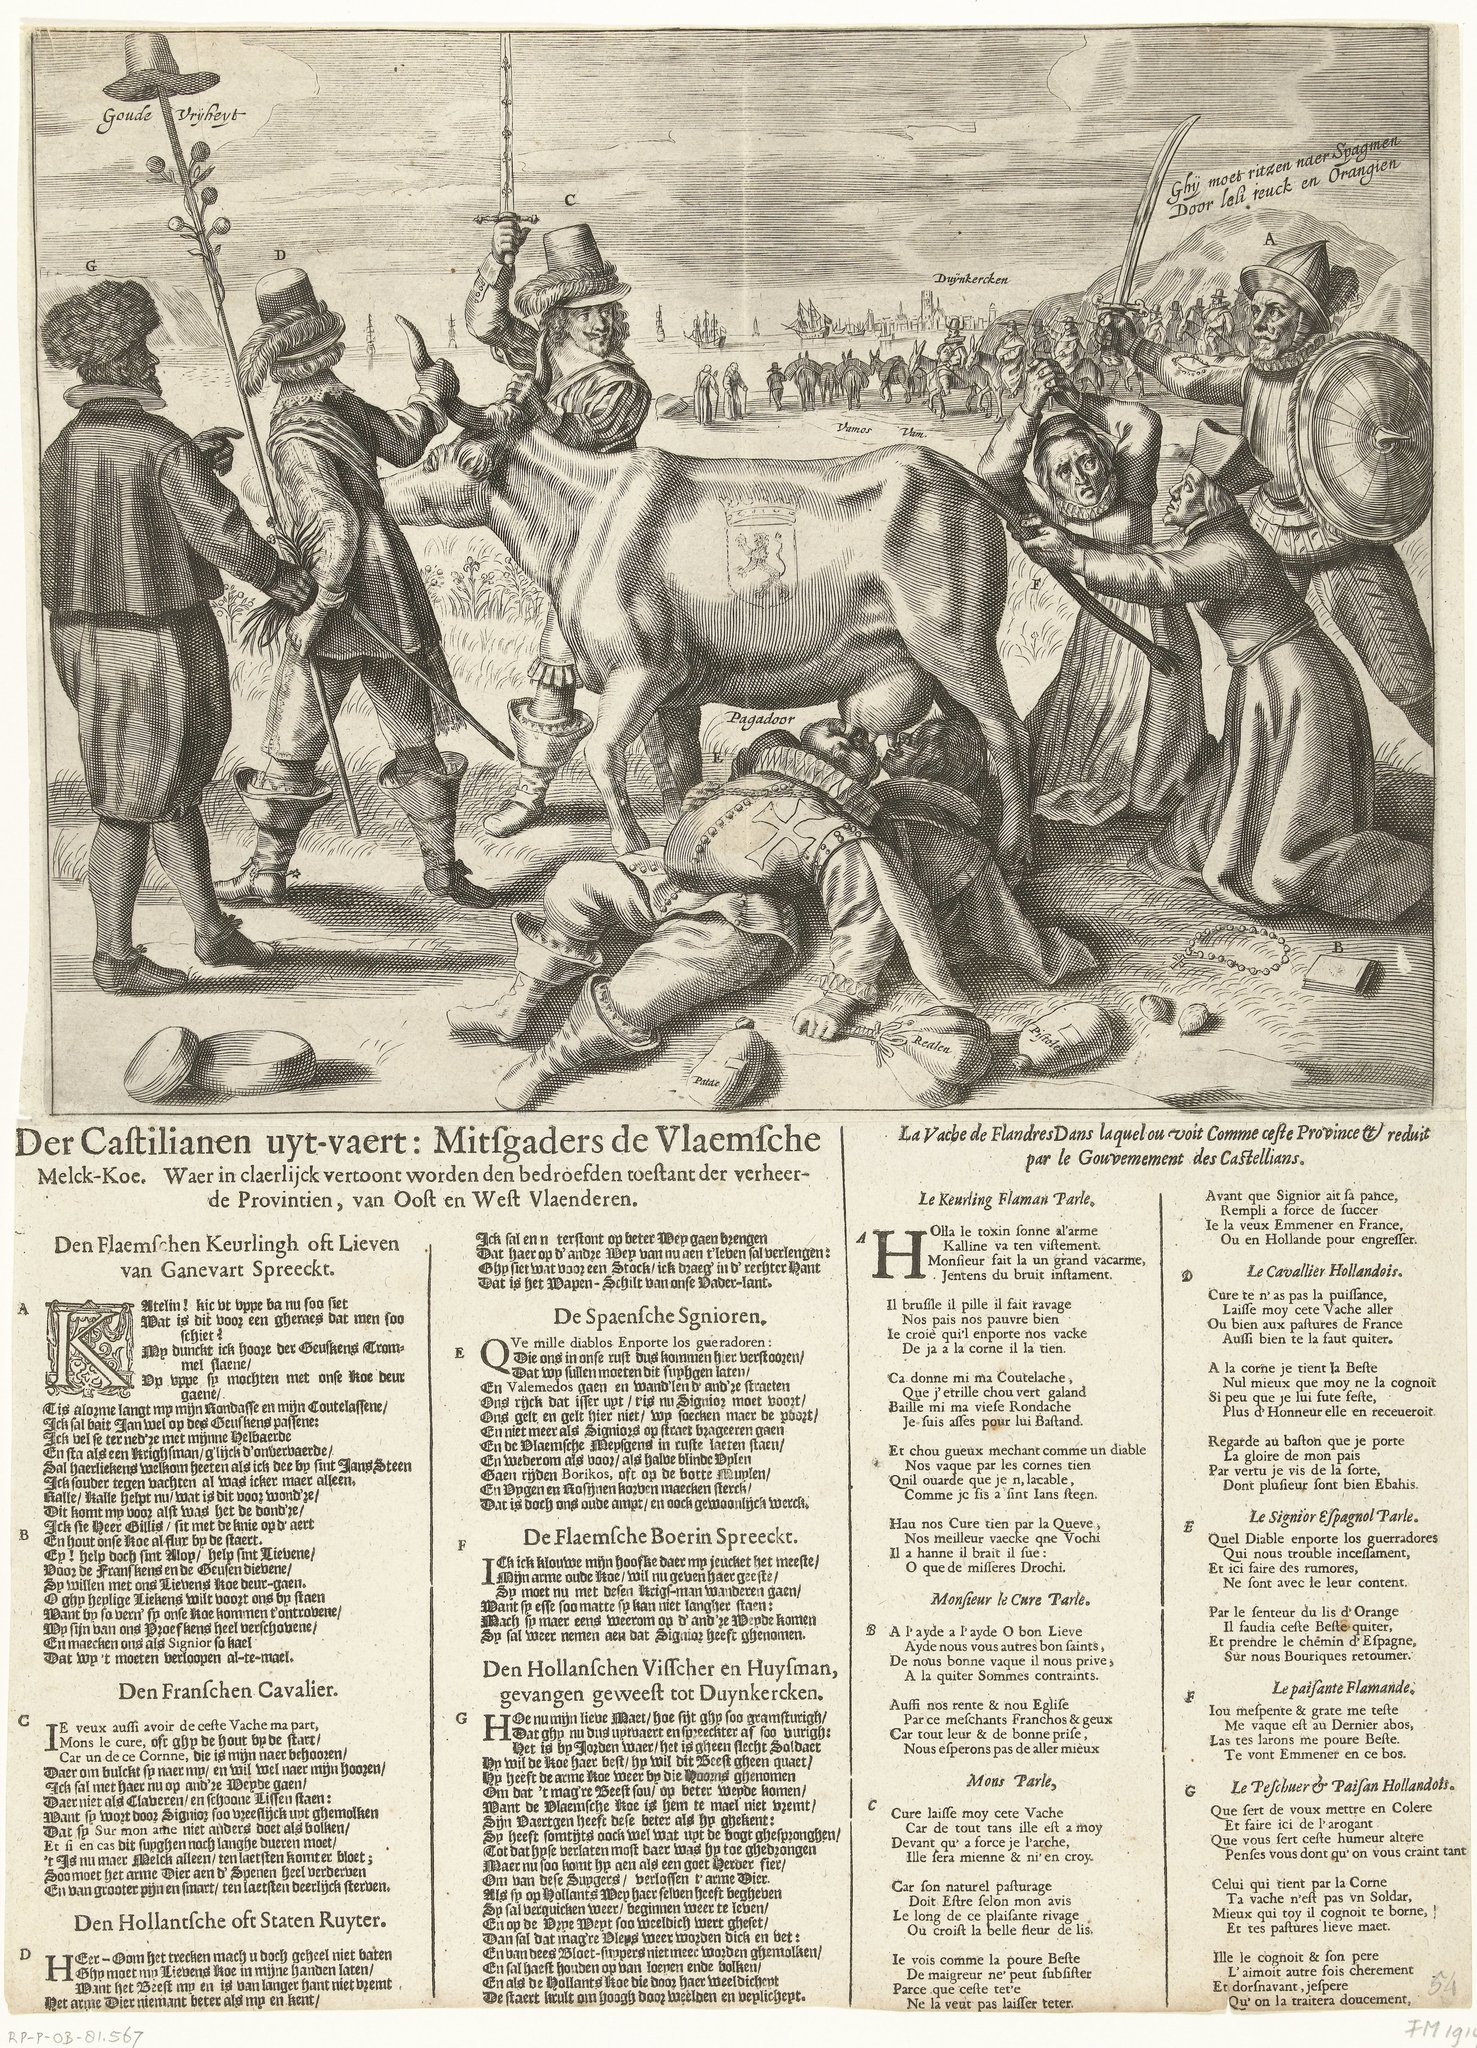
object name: print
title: Spotprent op het Spaanse verlies van Duinkerken, 1646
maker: crispijn van de passe (ii)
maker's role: draughtsman, print maker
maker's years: 1594-1670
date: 1646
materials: paper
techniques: engraving, letterpress printing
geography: northern netherlands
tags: cow, political caricatures and satires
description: Spotprent op de verovering van Duinkerken door het Franse leger op de Spanjaarden in 1646 en de deplorabele staat van de provincie Vlaanderen dat door Spanje wordt uitgebuit. De melkkoe Vlaanderen wordt bij de hoorns genomen en weggeleid door een Fransman (Franse Cavalier) en een Nederlander (Staatse Ruiter). Onder de koe liggen twee Spanjaarden (Spaanse Signoren) die zich vol drinken aan de uiers van de koe. Een Spaanse jezuïet en een Vlaamse soldaat proberen de koe nog te behouden. Linksvoor een Hollandse Matroos. Op de achtergrond vertrekt een zwaar beladen stoet richting Spanje. Onder de prent is een tekstblad geplakt met 2 kolommen in het Nederlands en 2 kolommen in het Frans waarin de personen A-G uit de voorstelling spreken.